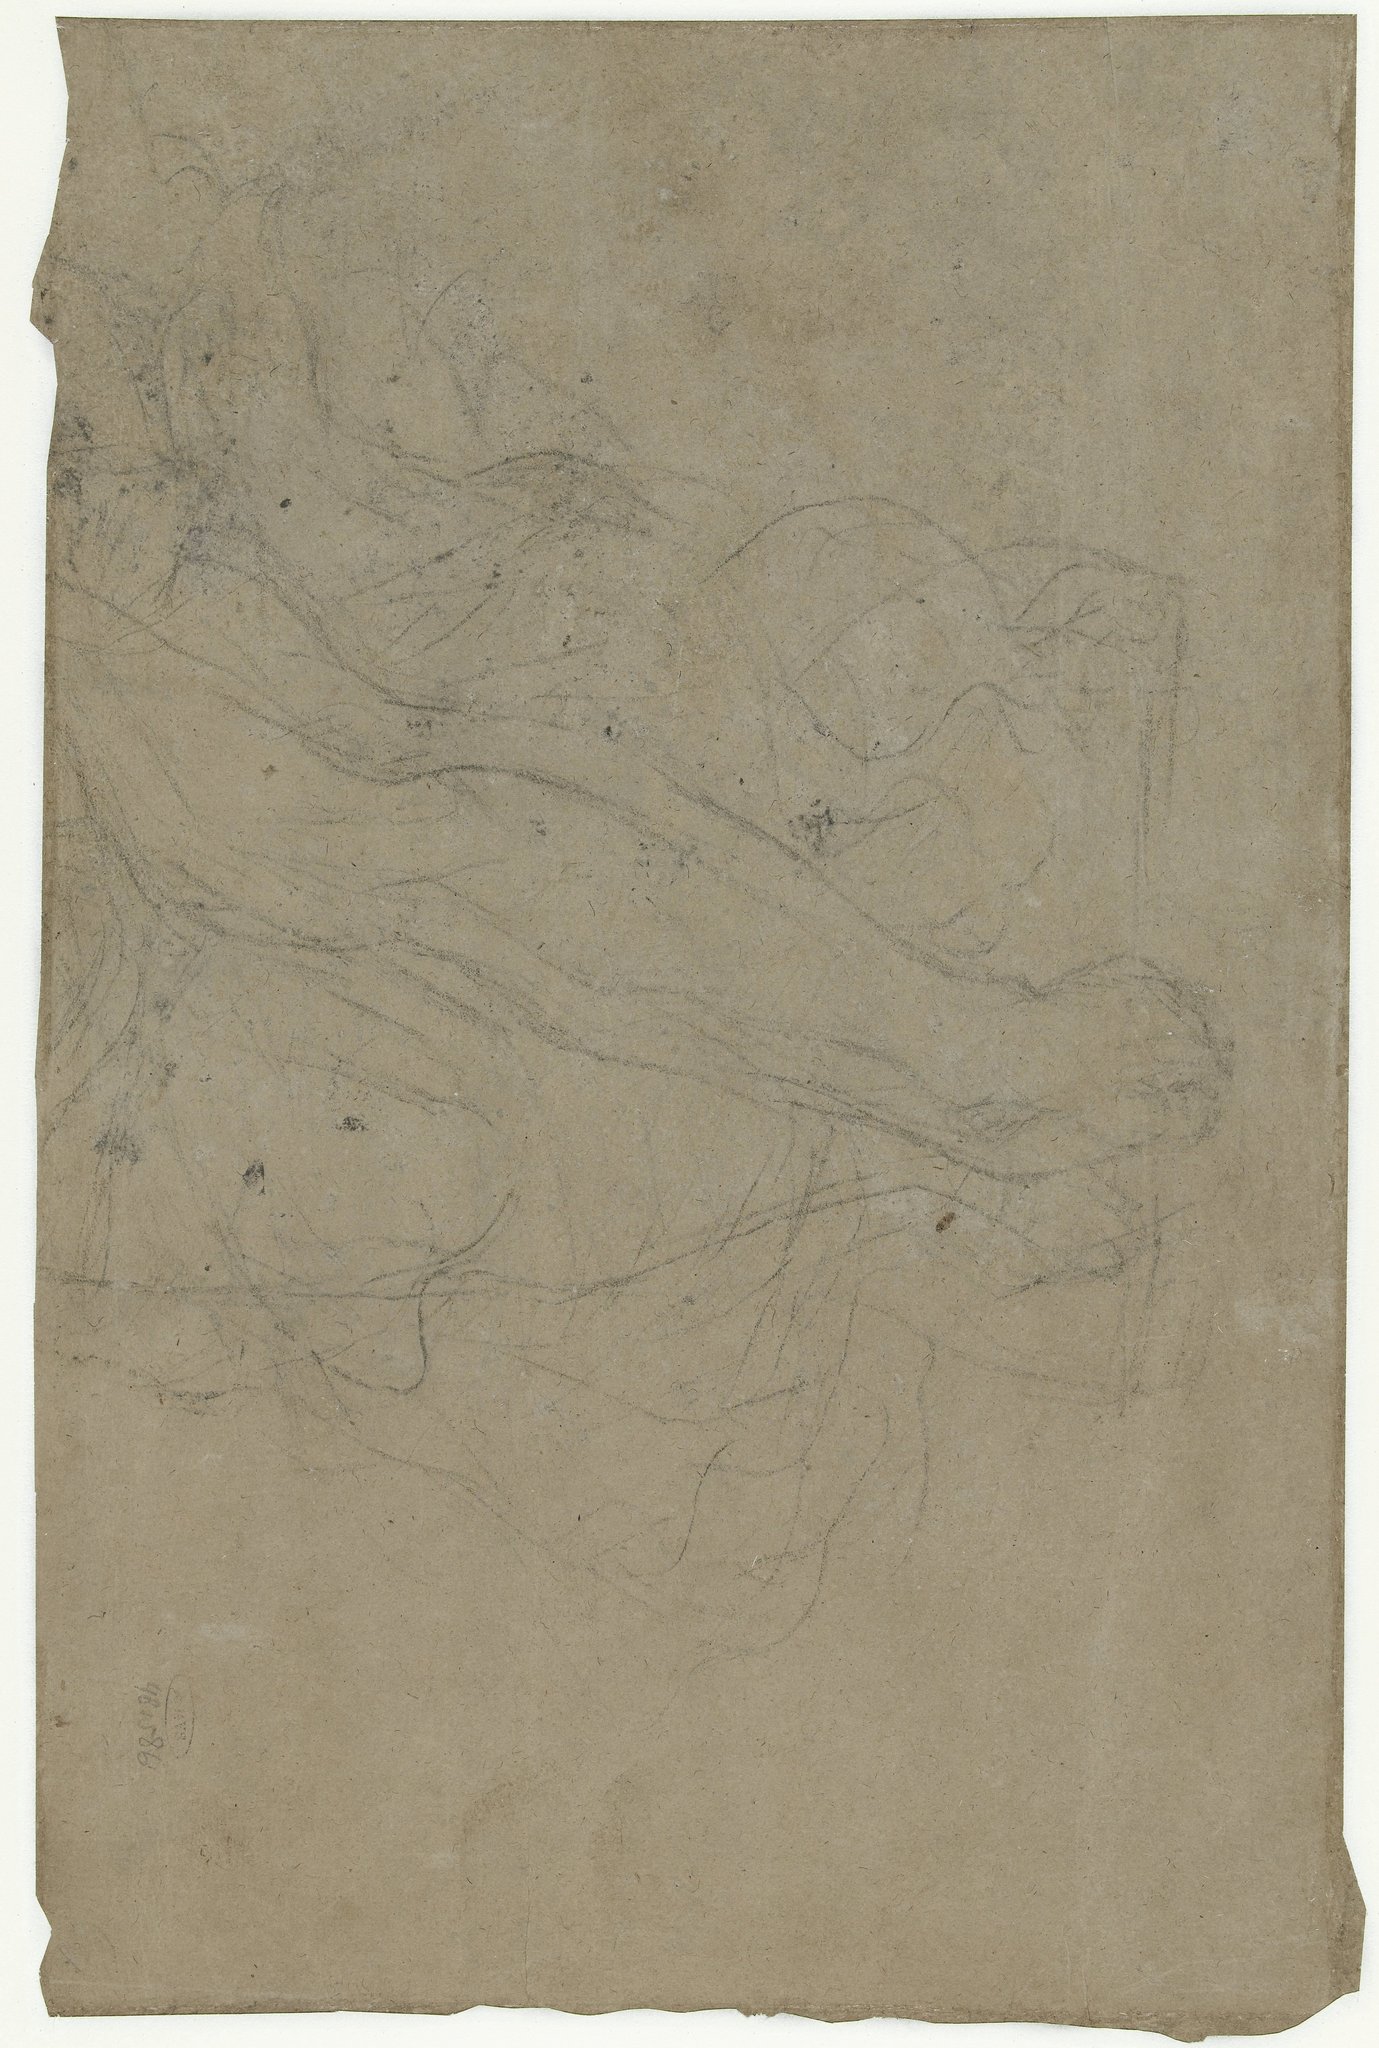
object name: drawing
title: Deel van een studie van een liggend figuur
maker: jean-françois de troy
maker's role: draughtsman, painter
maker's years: 1679-1752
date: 1689-1752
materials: chalk, paper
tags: lying figure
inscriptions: collector's mark: Lugt 2228a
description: Schetsblad met deel van een studie van een liggend figuur.